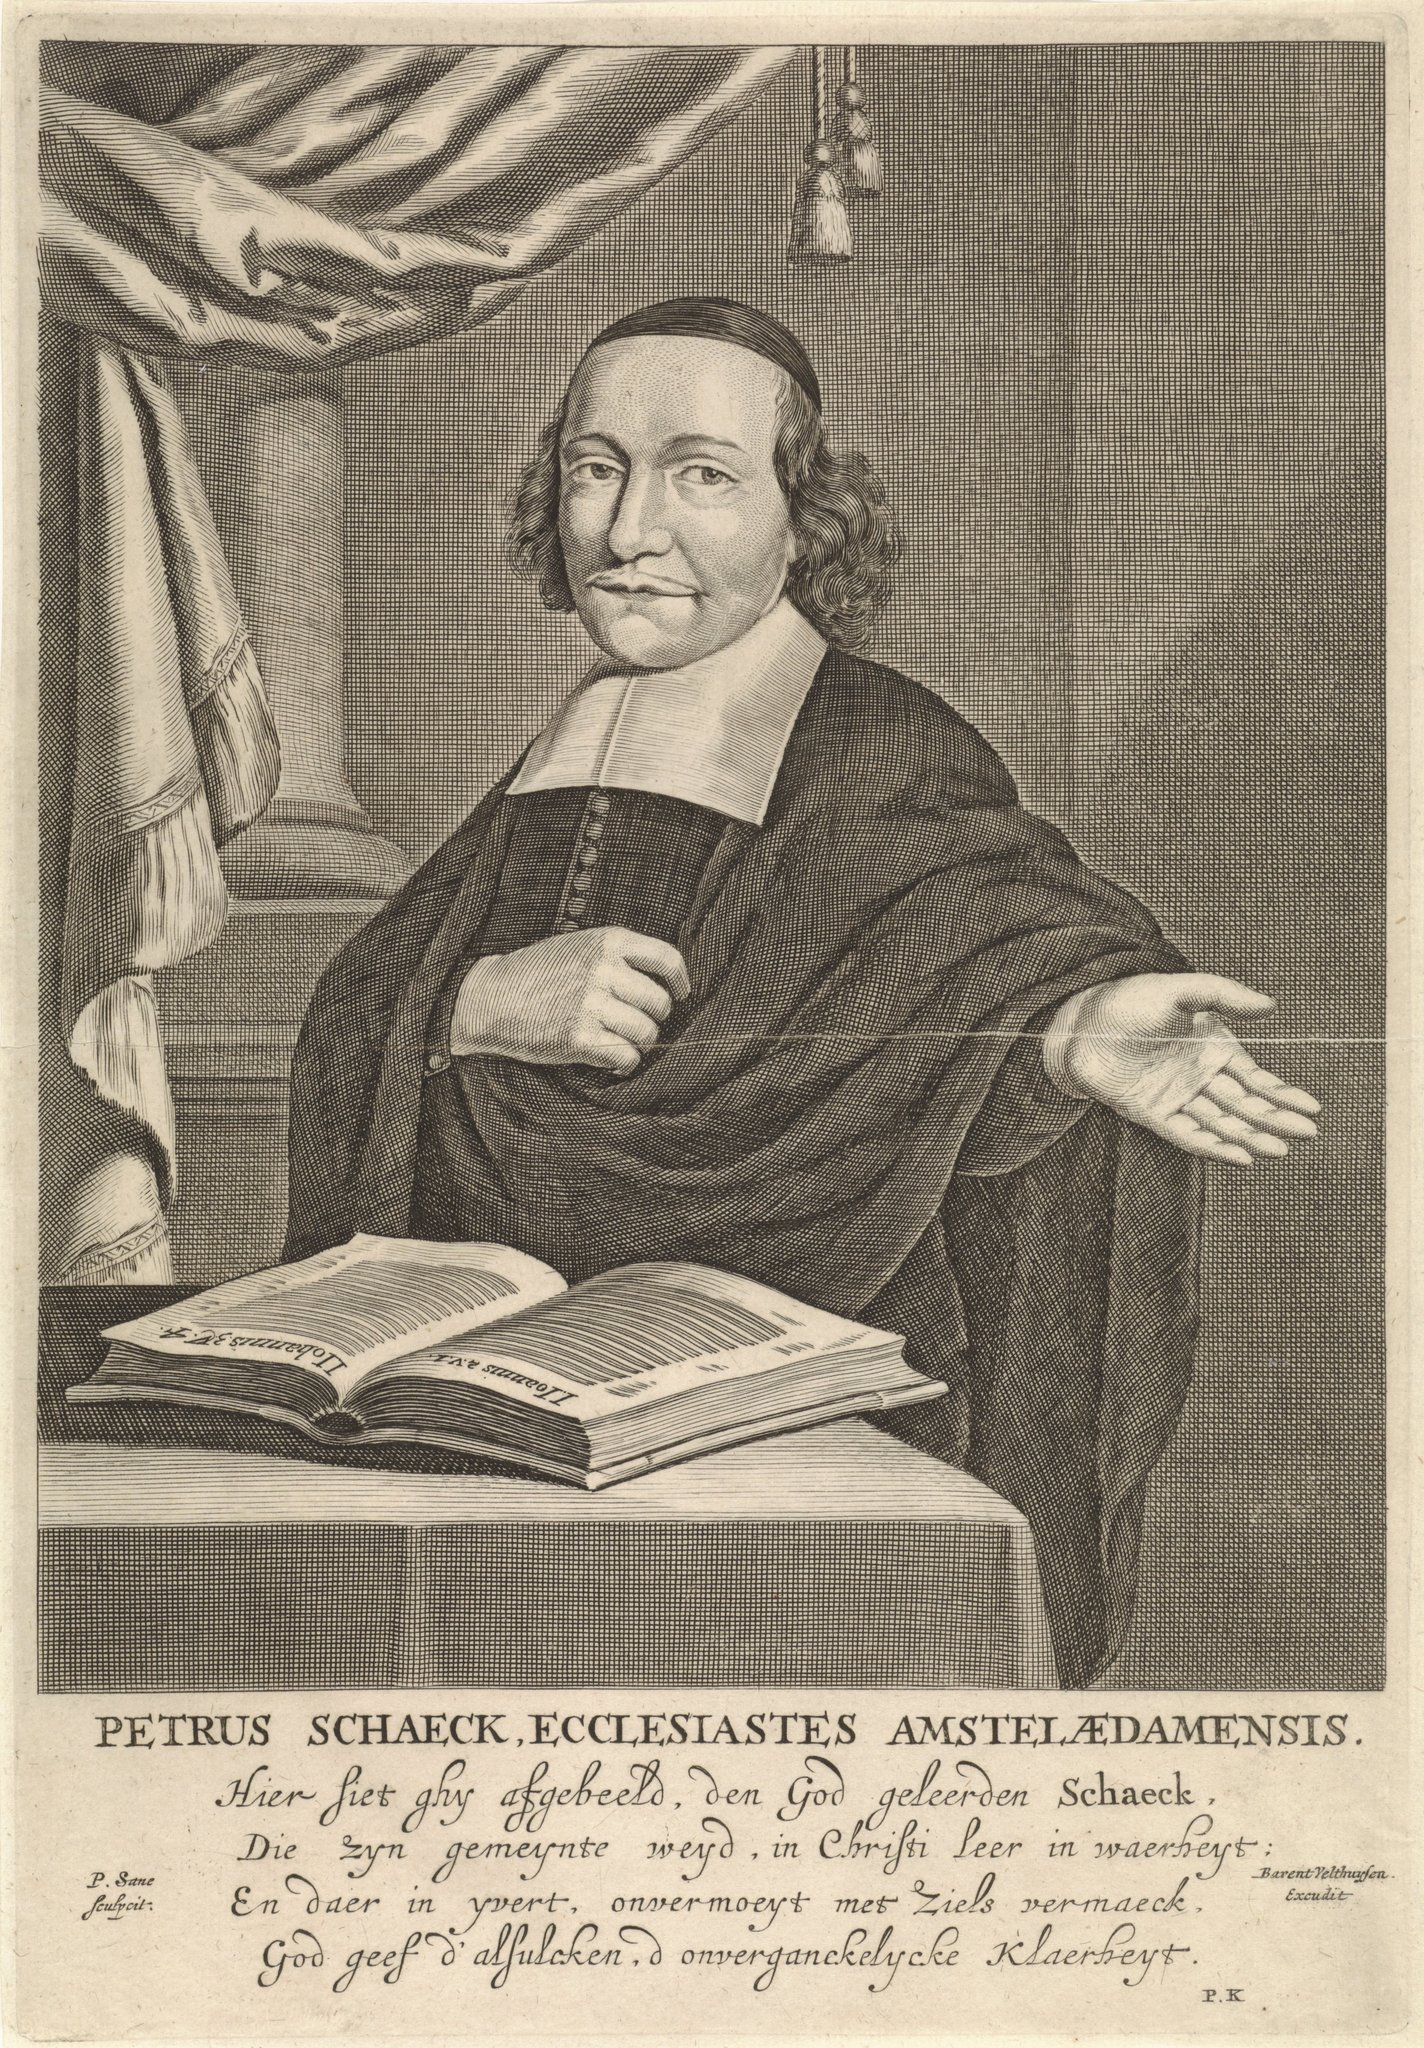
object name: print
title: Portret van de Amsterdamse predikant Petrus Schaeck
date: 1700-1750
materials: paper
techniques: engraving, etching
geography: amsterdam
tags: predikant, petrus schaeck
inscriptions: collector's mark: Lugt 2228